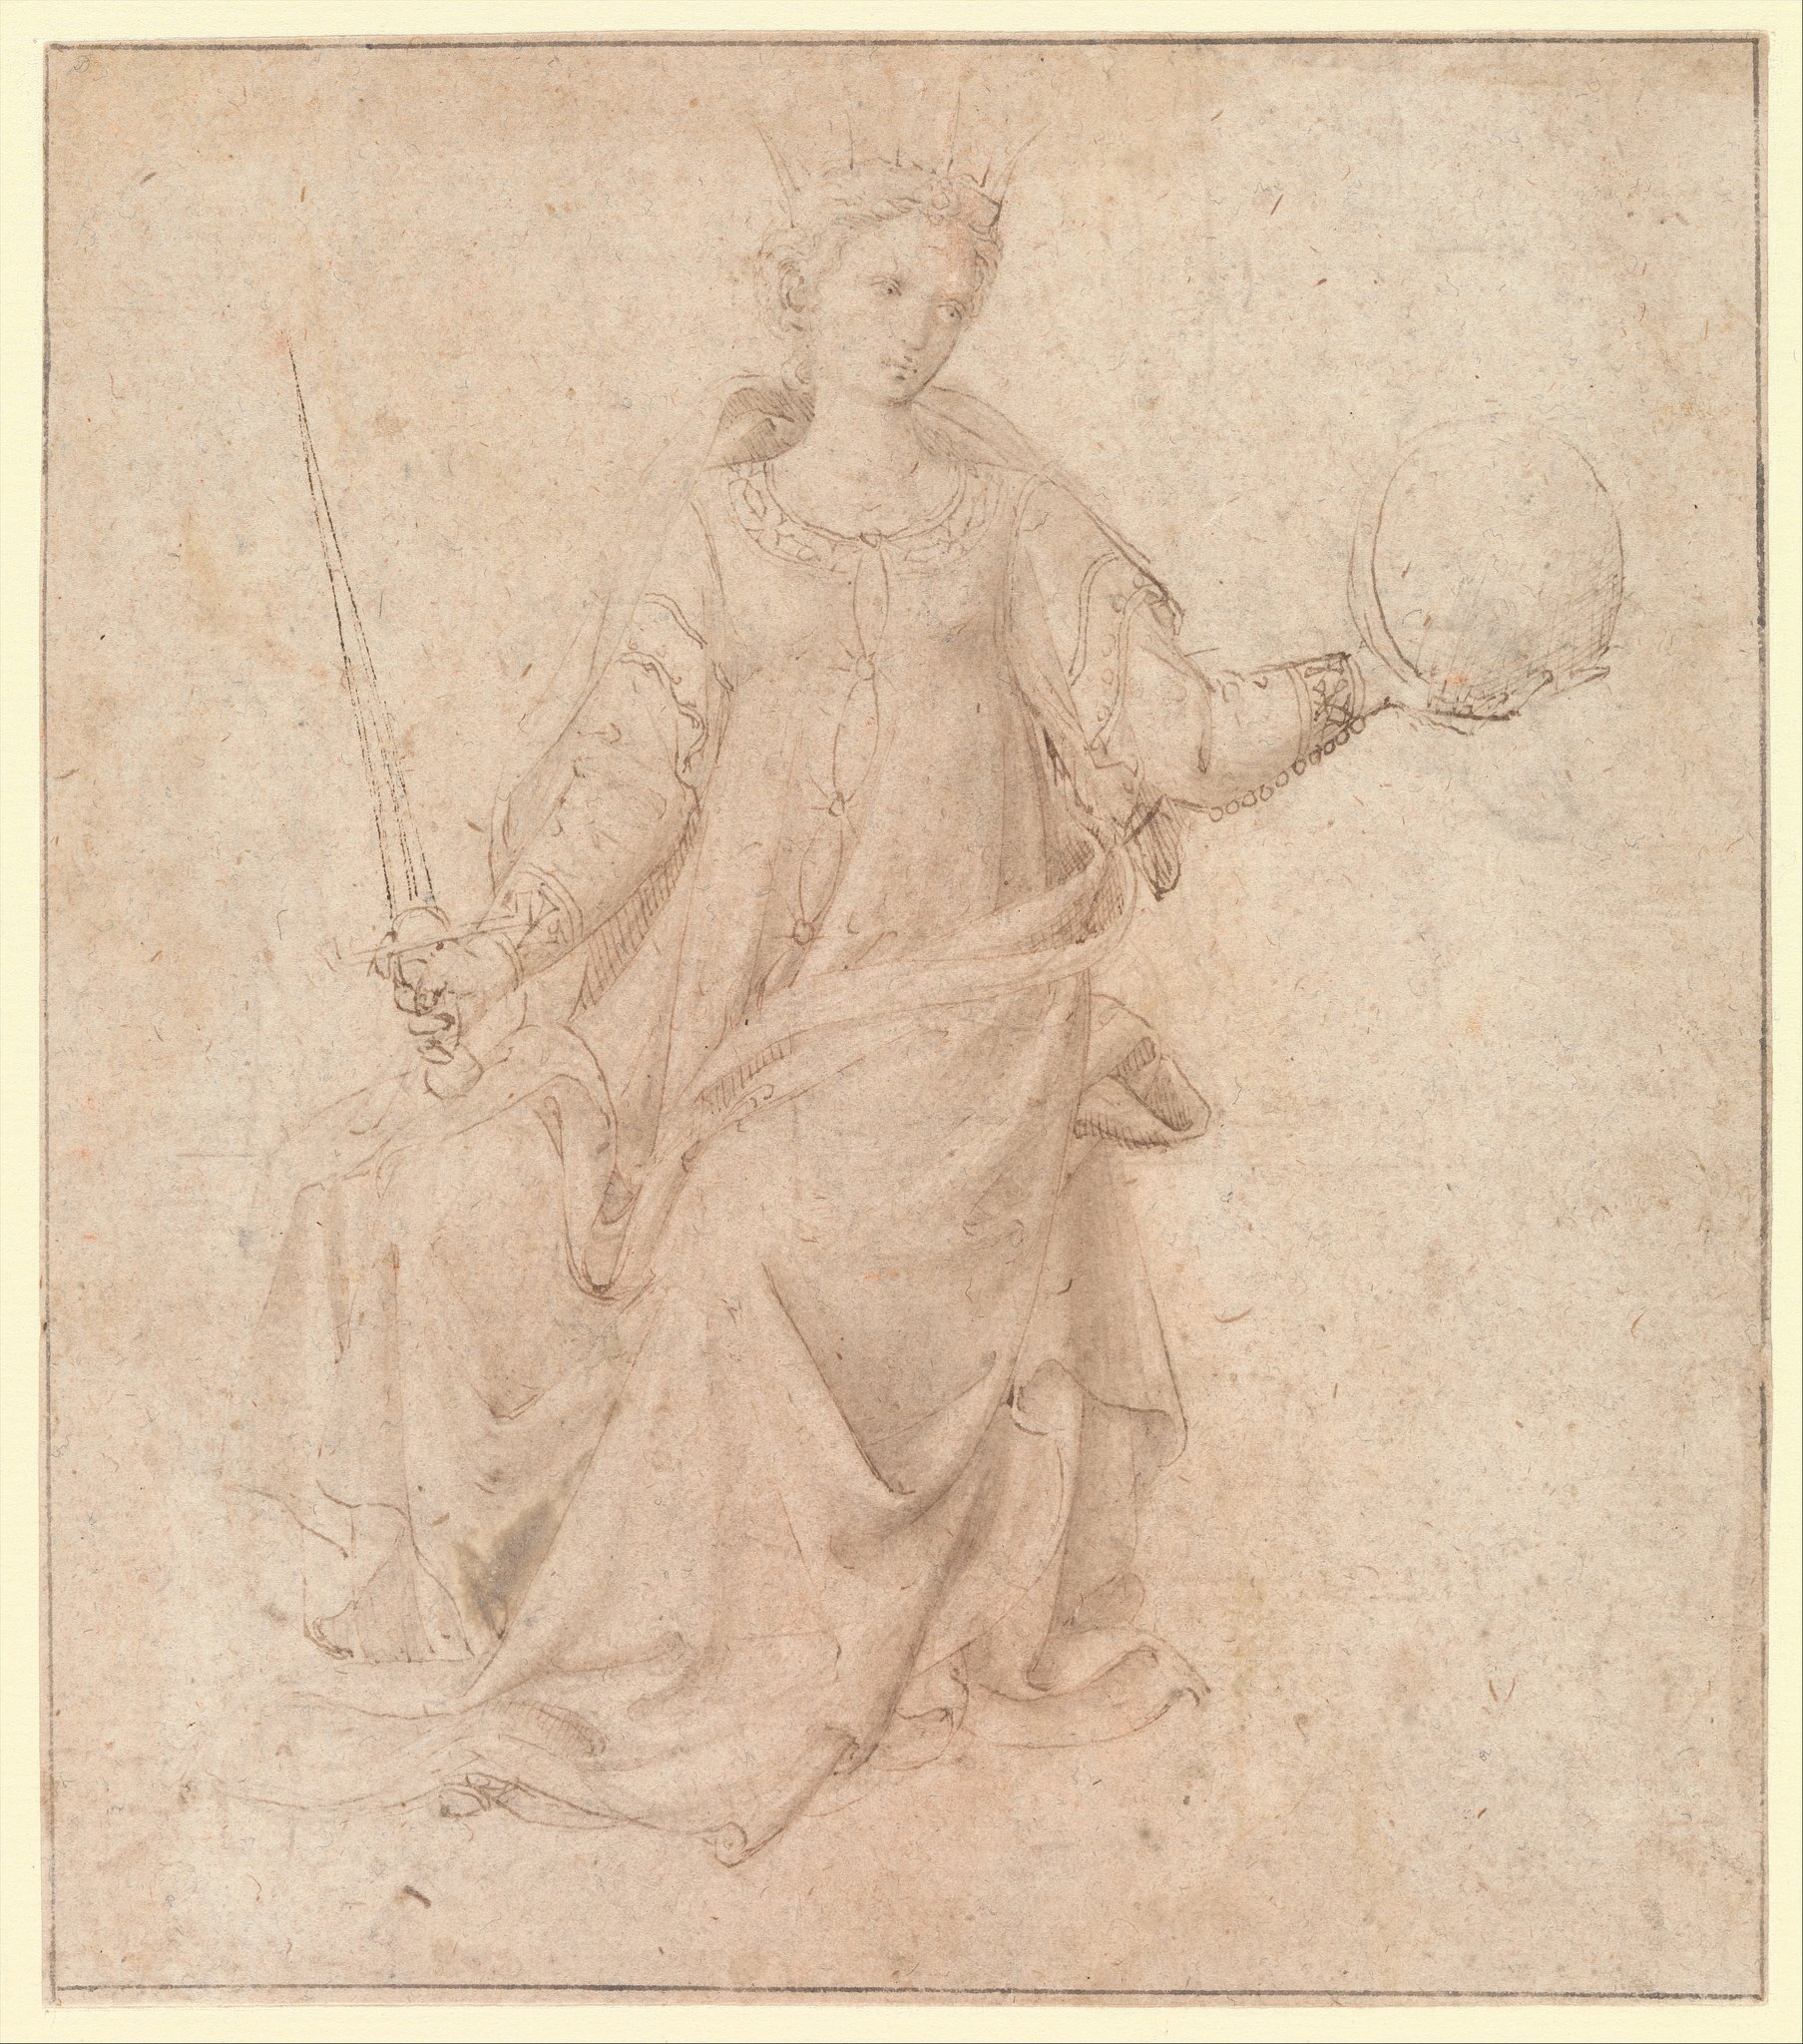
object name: drawing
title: Justice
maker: fra angelico (guido di pietro)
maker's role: artist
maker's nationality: italian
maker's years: 1395-1455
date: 1440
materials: ink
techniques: brush, pen, wash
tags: women,globes